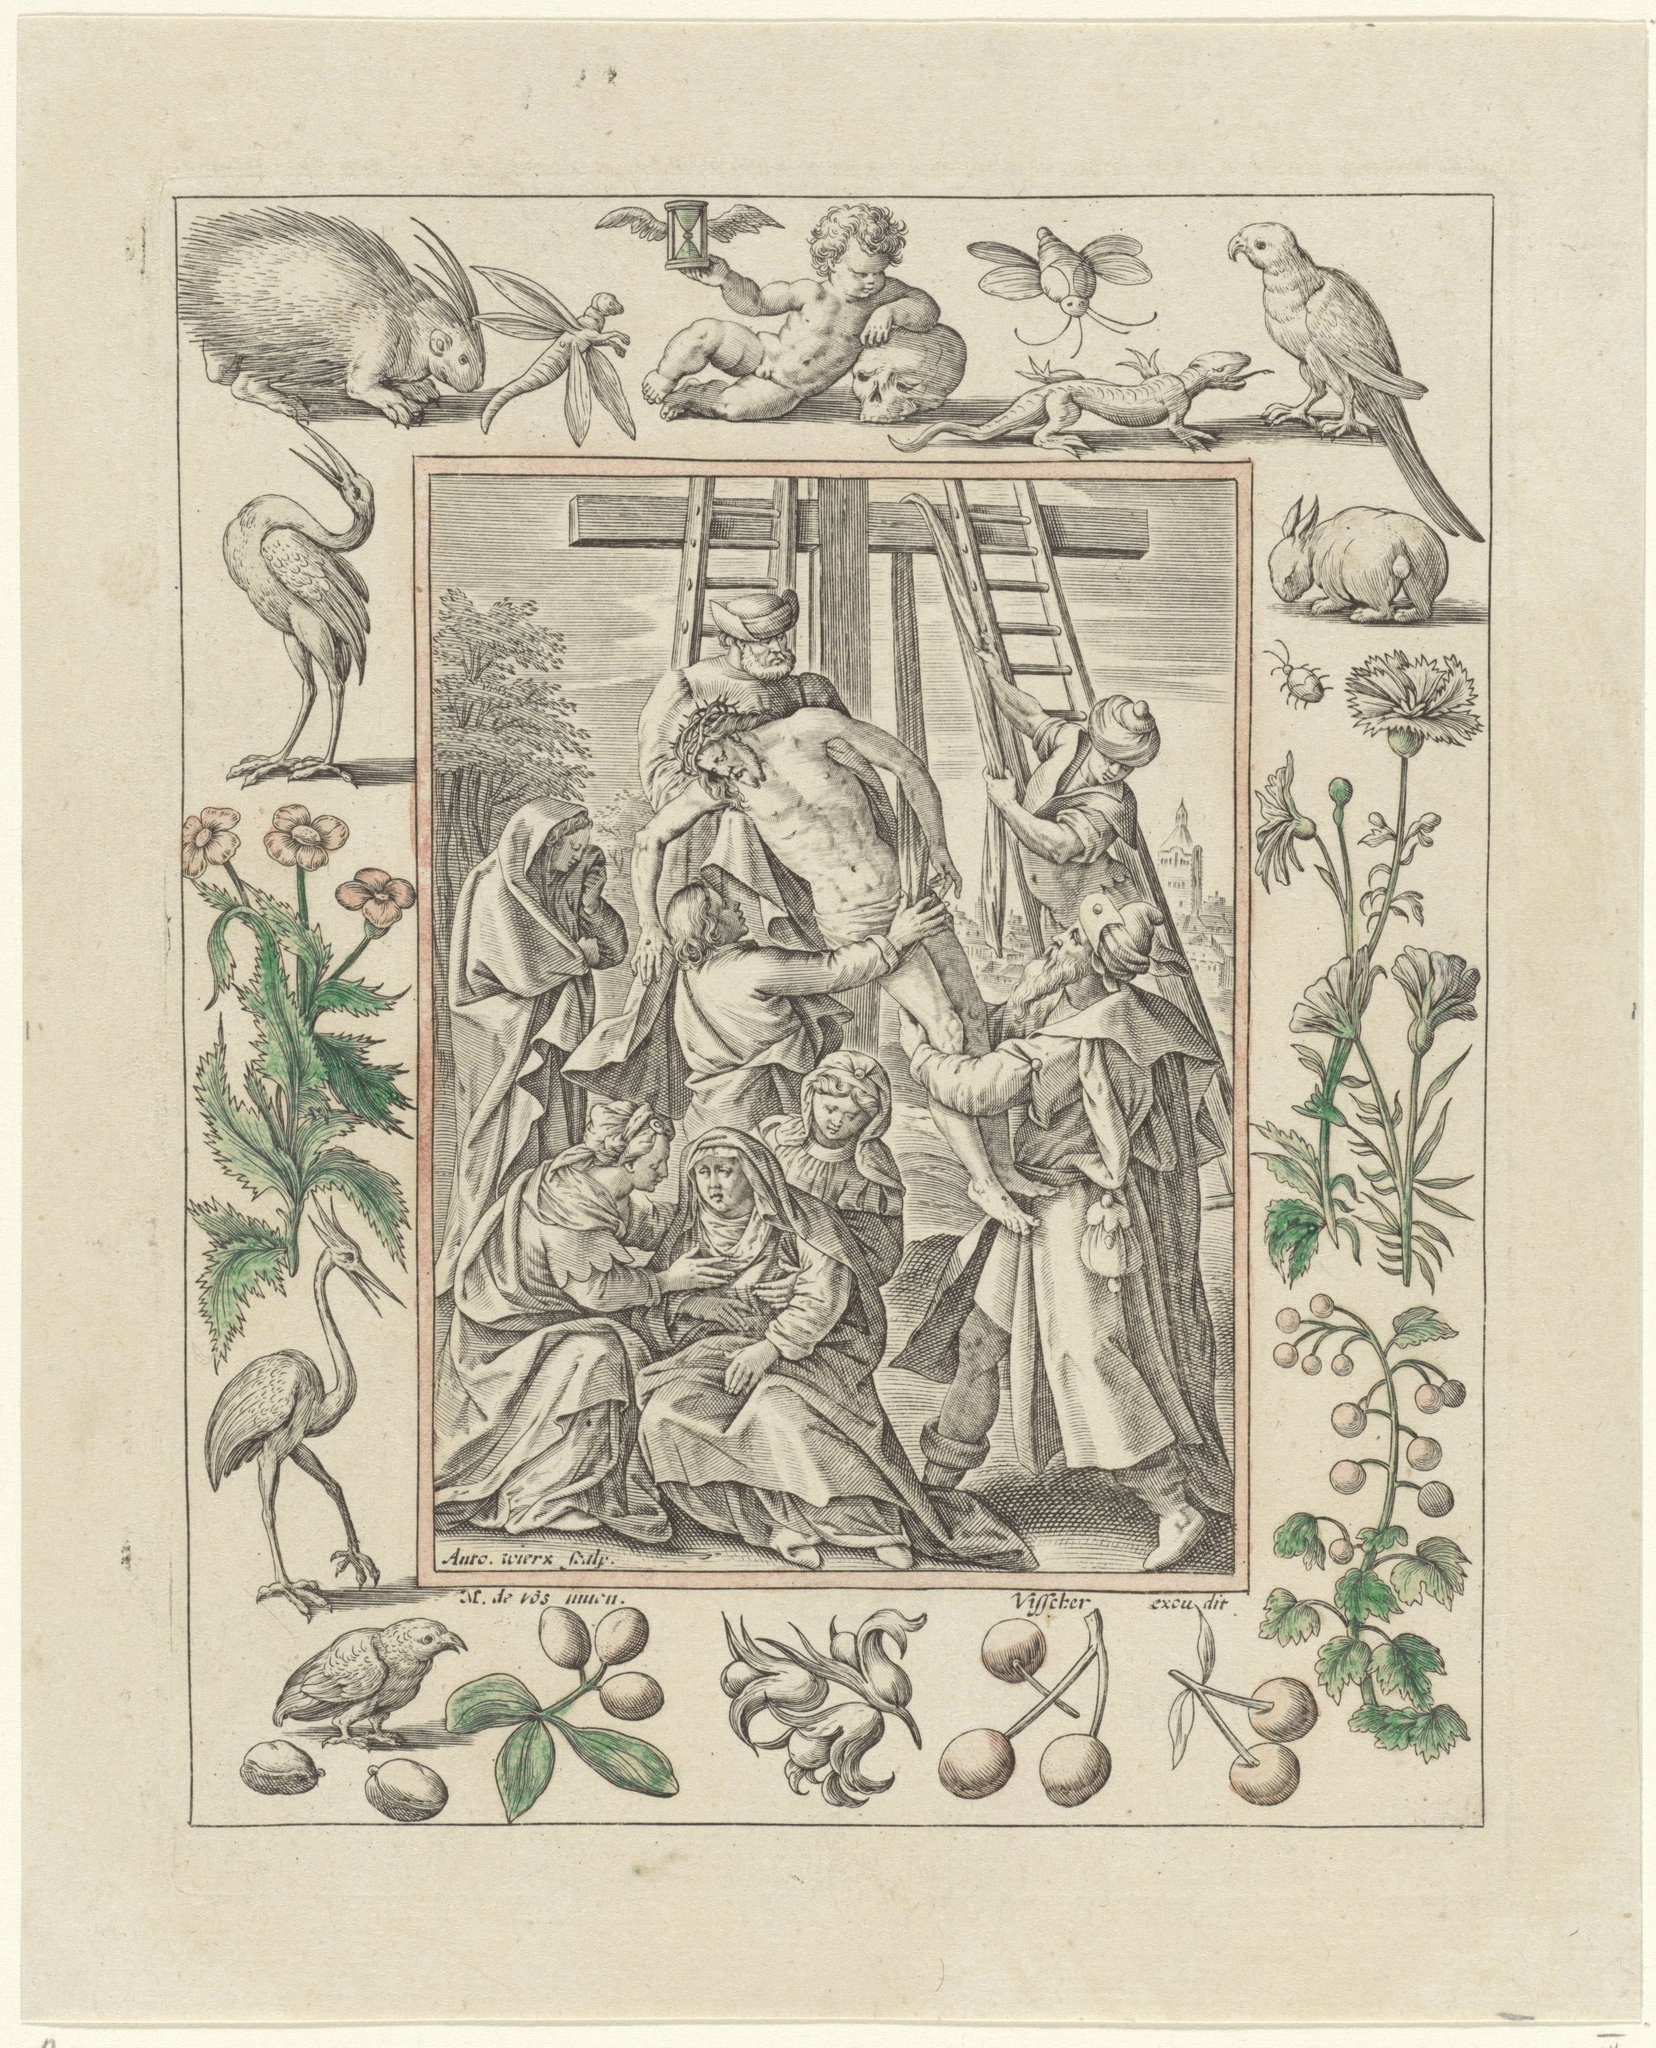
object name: print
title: Kruisafneming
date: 1582-1586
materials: paper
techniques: engraving, hand coloring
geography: amsterdam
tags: flowers, descent from the cross: christ is taken down from the cross, usually by nicodemus and joseph of arimathaea who are standing on the ladders (both arms of christ detached), animals, 'vanitas' symbols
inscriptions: collector's mark: Lugt 2228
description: Het lichaam van Christus wordt door Nikodemus, Jozef en twee onbekende mannen van het kruis gehaald. Maria, Maria Magdalena en andere vrouwen treuren. De voorstelling is gevat in een ornamentele omlijsting die is gedecoreerd met dieren, bloemen, en een putto met vanitassymbolen.